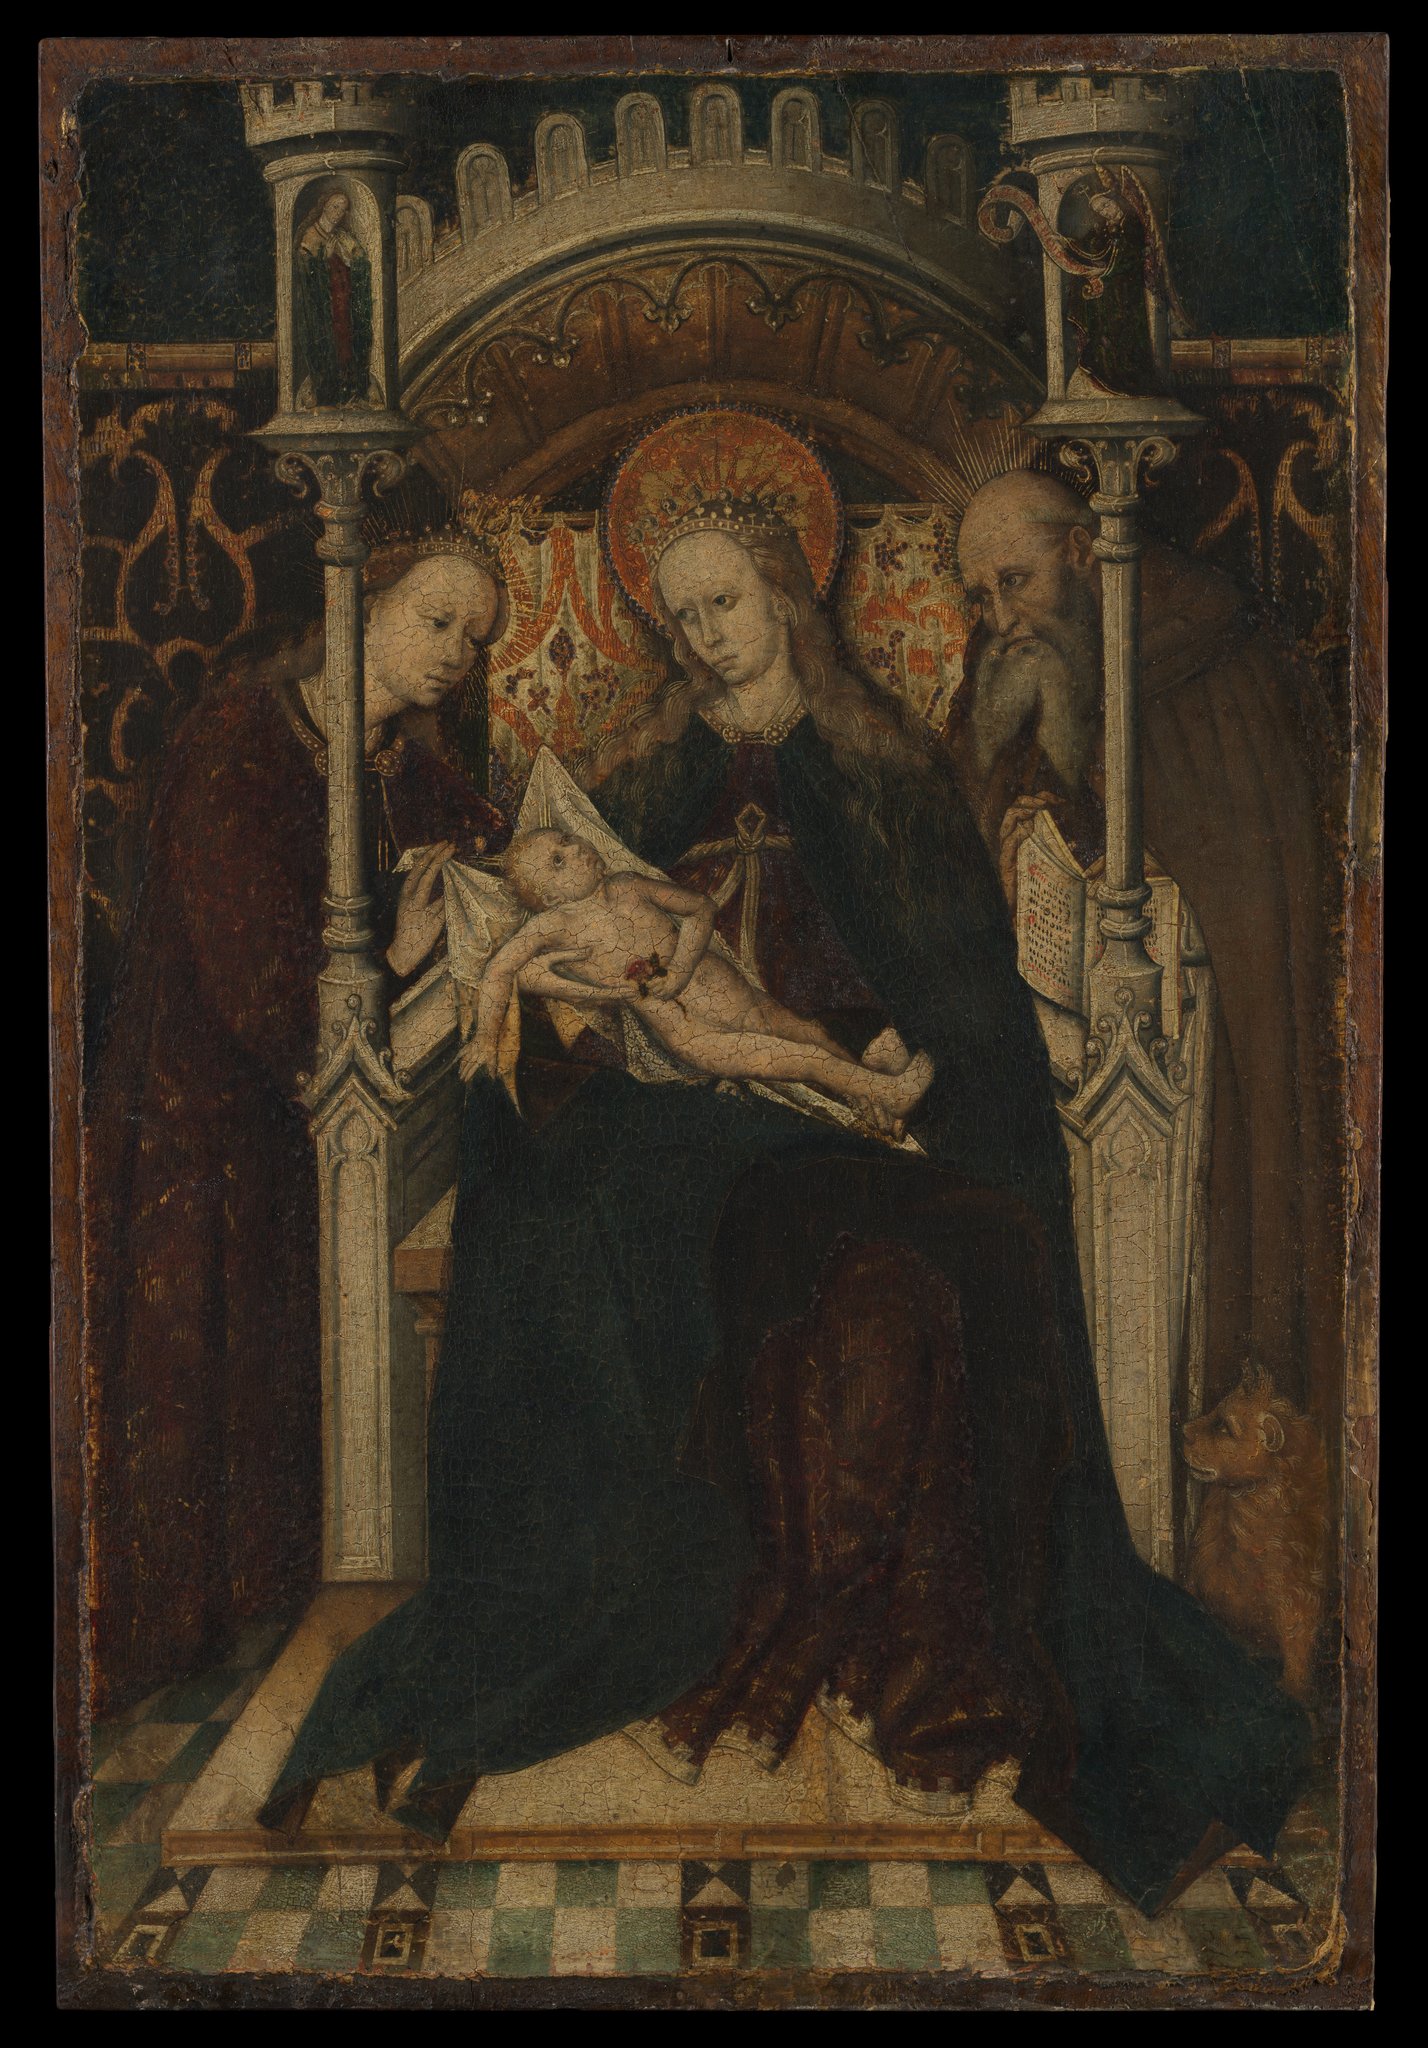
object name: painting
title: Virgin and Child Enthroned with Saints Catherine and Jerome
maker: spanish painter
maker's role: artist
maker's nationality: spanish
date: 1430-1469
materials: gold, oil, paint, wood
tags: madonna and child,saint catherine,saint jerome